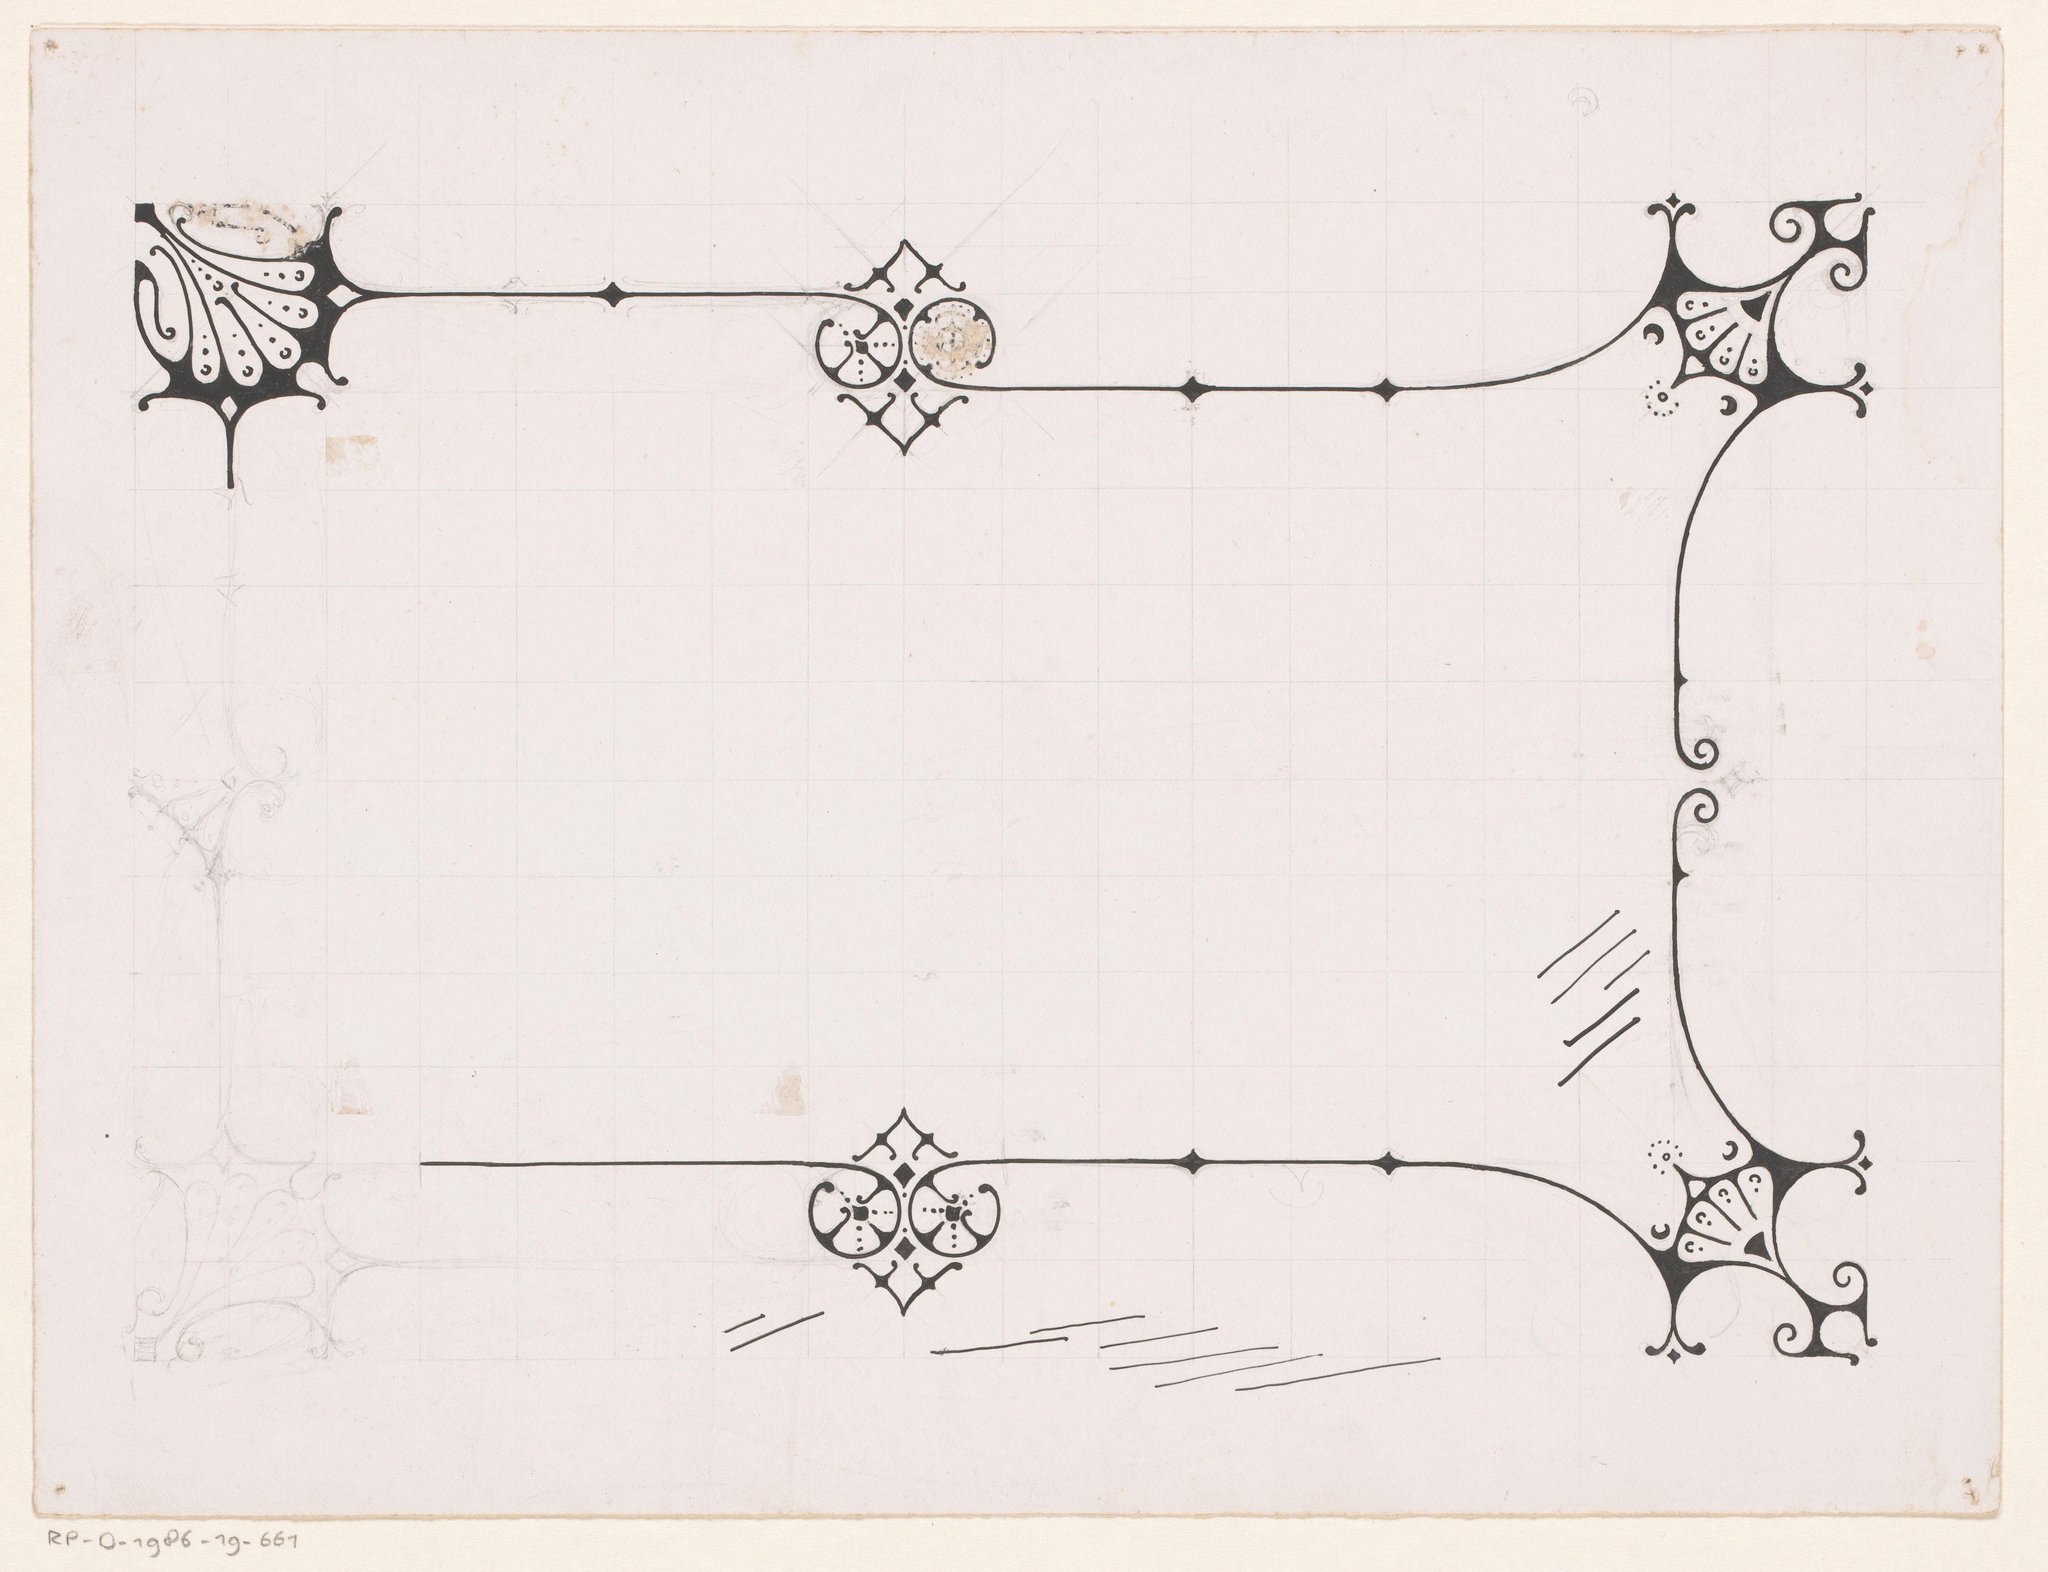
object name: design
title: Ontwerp voor een kader voor Elsevier's Geïllustreerd Maandschrift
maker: reinier willem petrus de vries (1874-1953)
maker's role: draughtsman, print maker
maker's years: 1874-1953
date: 1905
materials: ink, paper, pencil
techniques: pen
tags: ornaments ~ art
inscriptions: collector's mark: ‘R:MVS.’